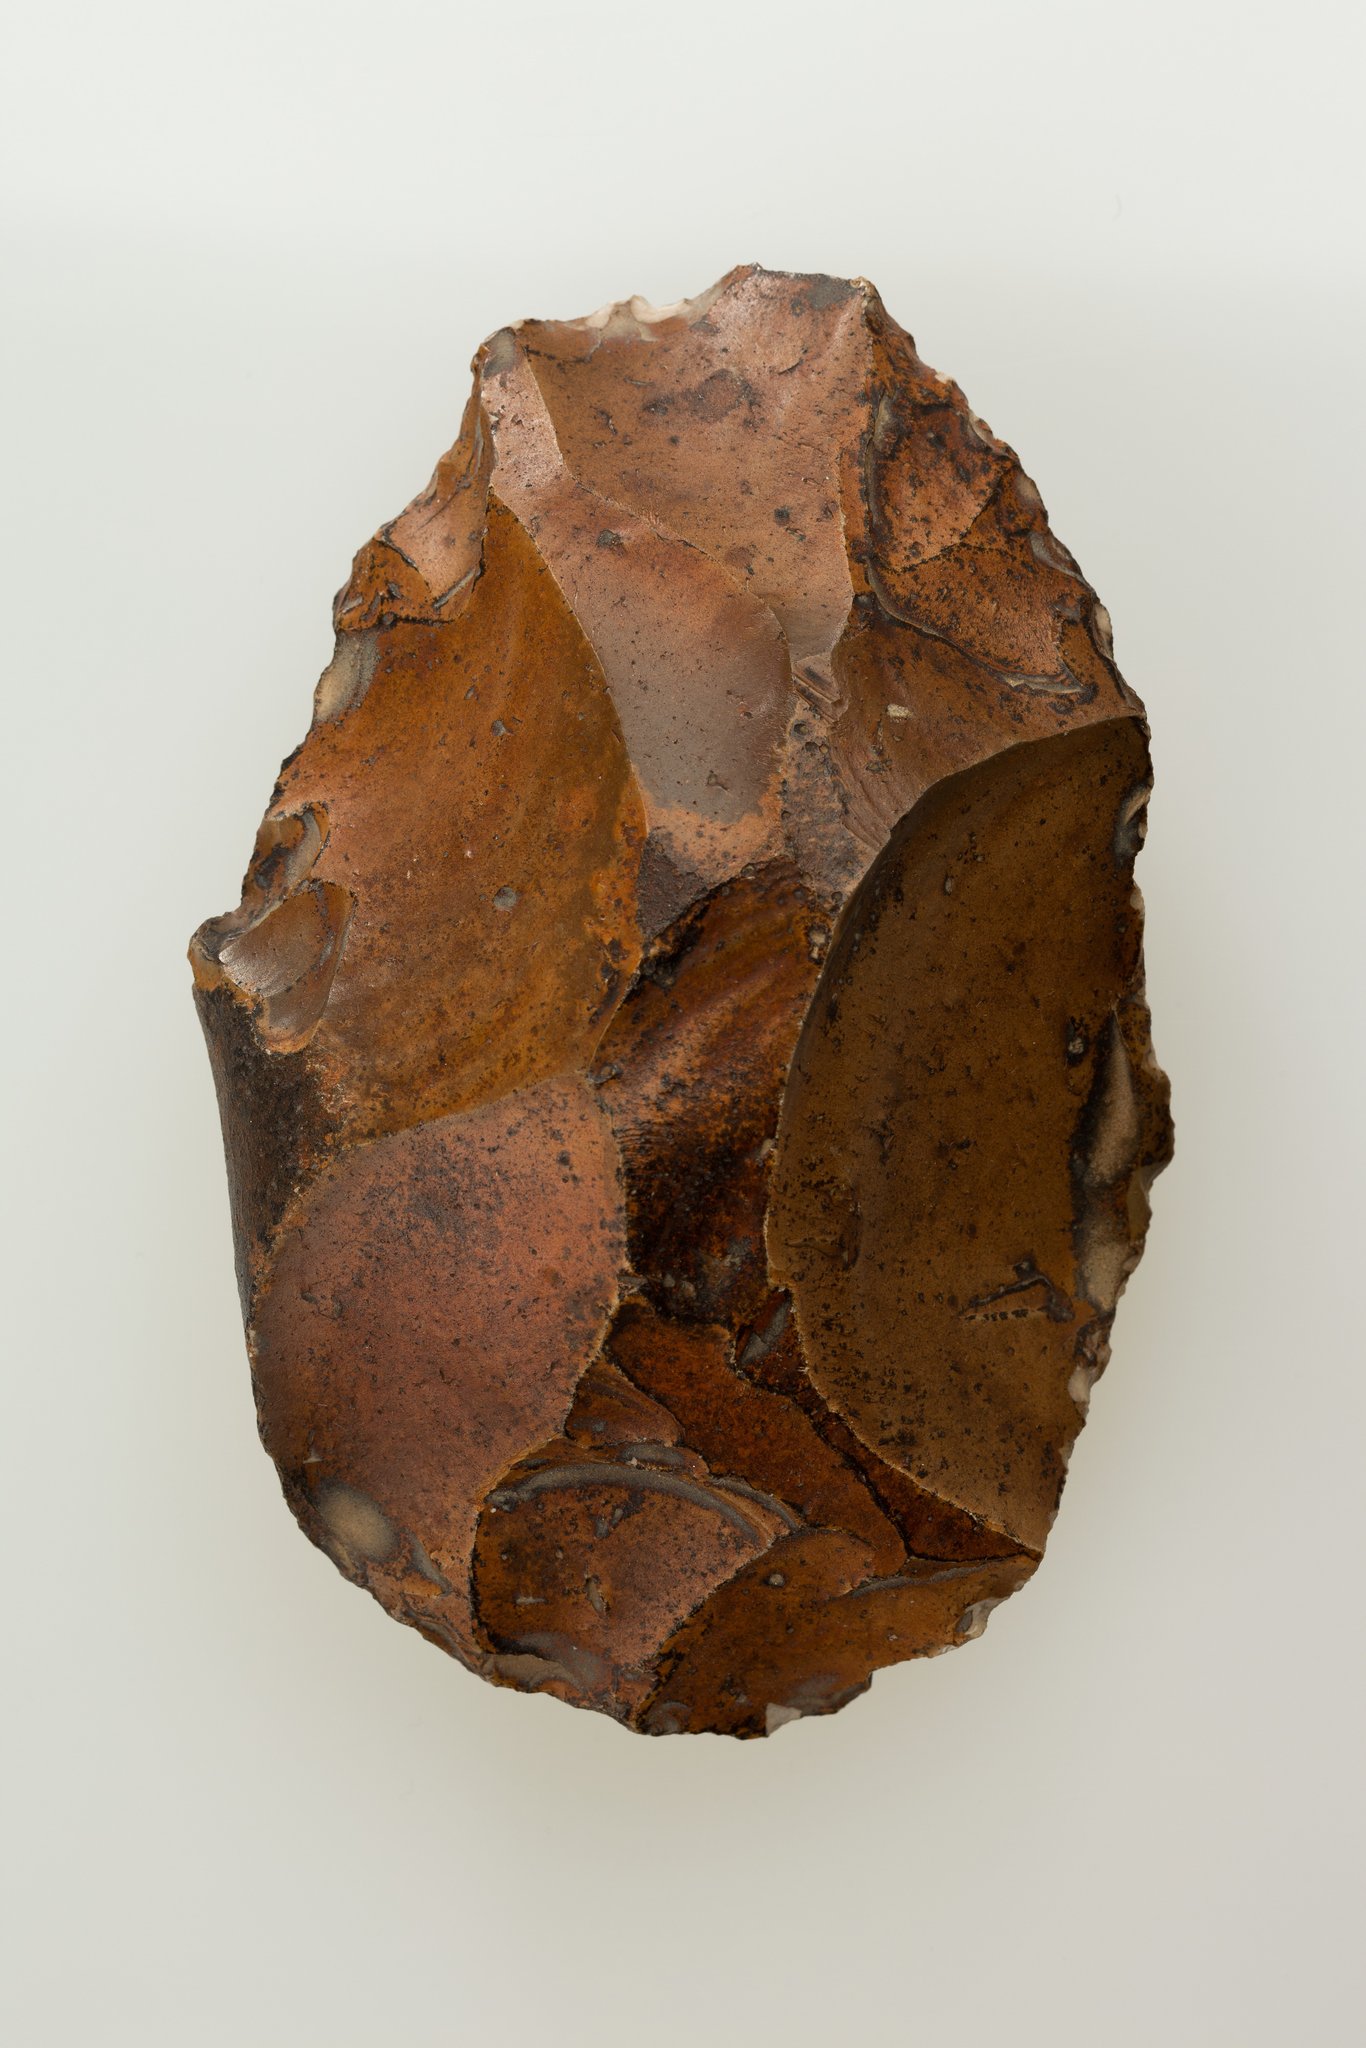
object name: tool, biface, hand axe, ovate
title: Biface, commonly referred to as a hand ax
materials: stone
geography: egypt